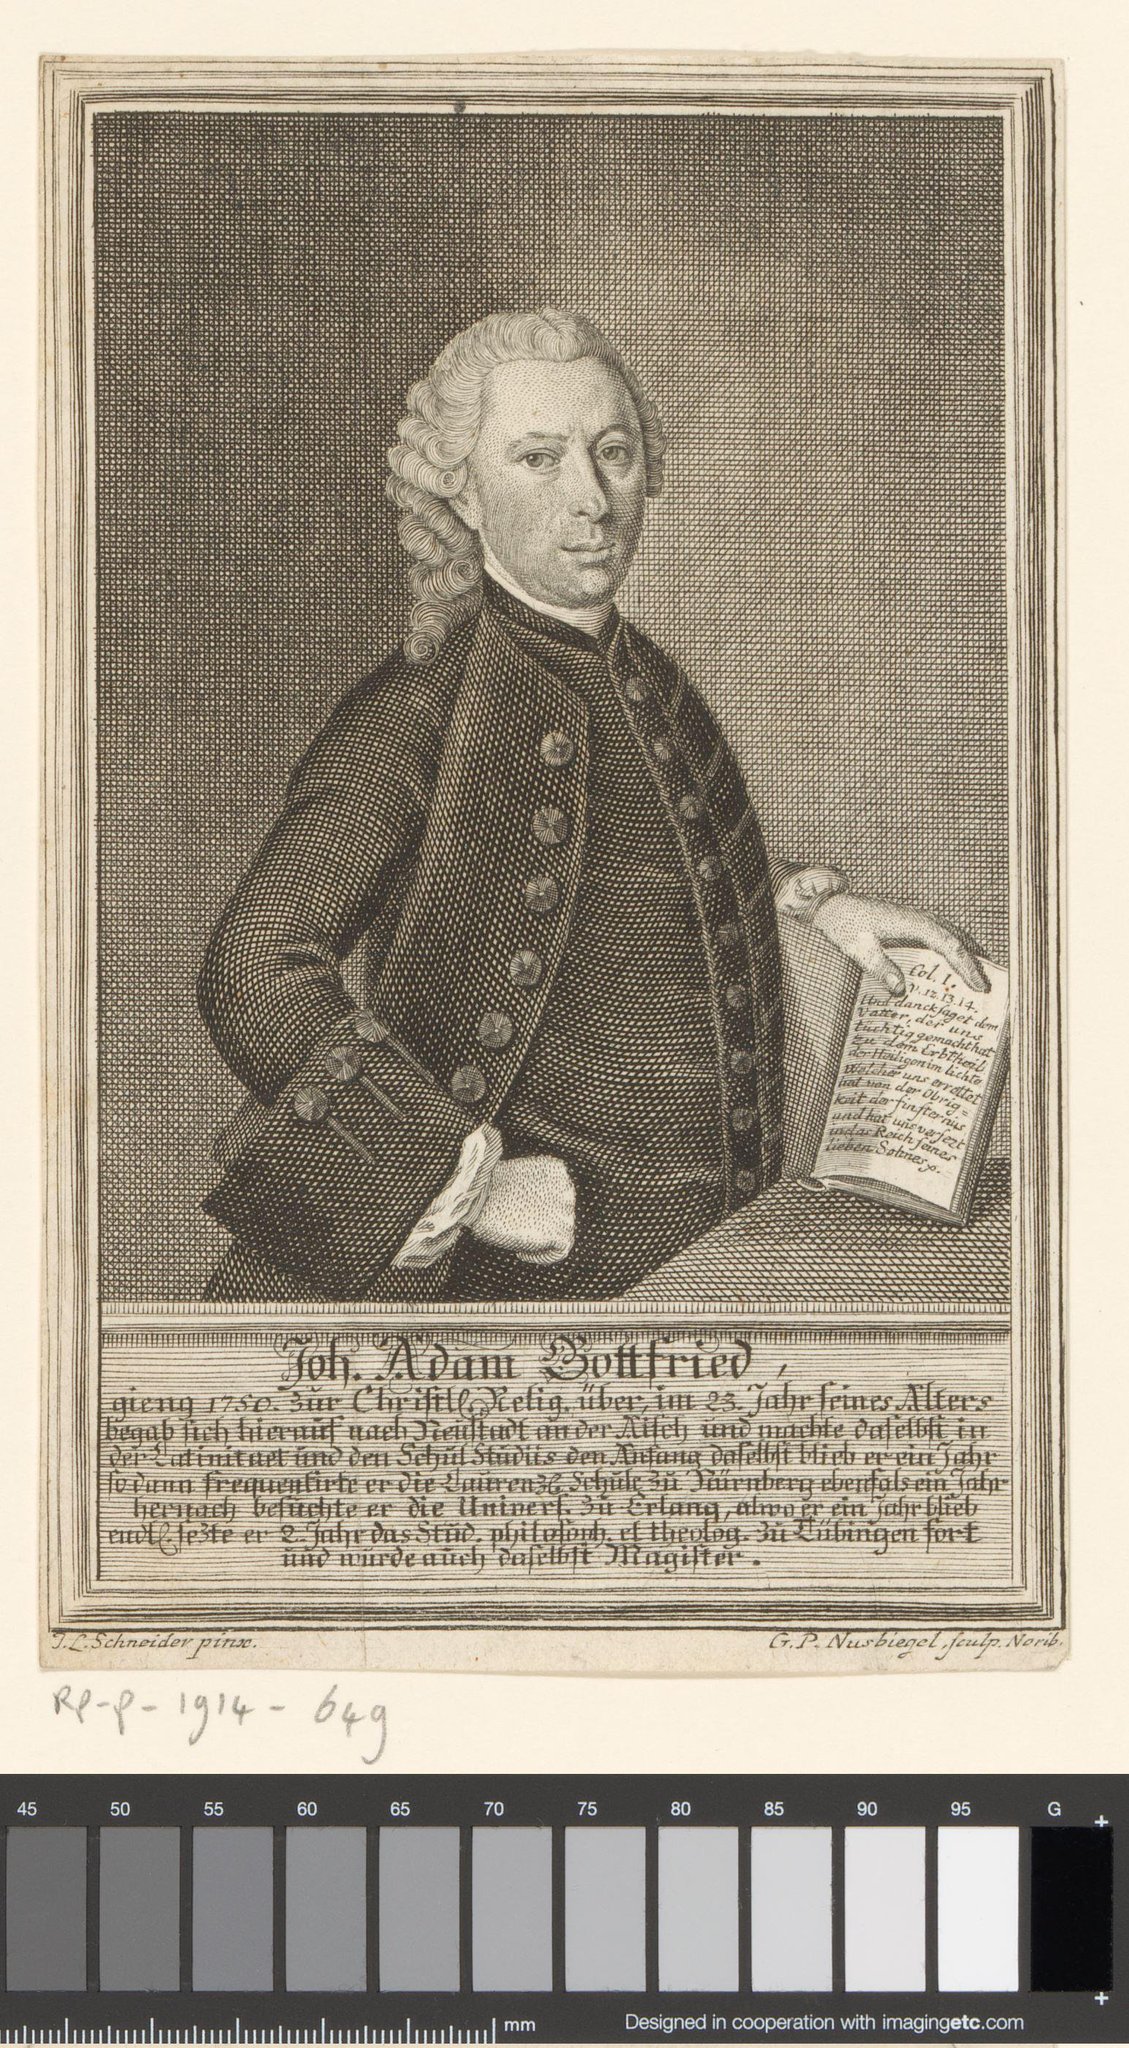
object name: print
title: Portret van Johann Adam Gottfried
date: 1755-1786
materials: paper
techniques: engraving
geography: nuremberg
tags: missionary, historical persons, book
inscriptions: collector's mark: Lugt 2228